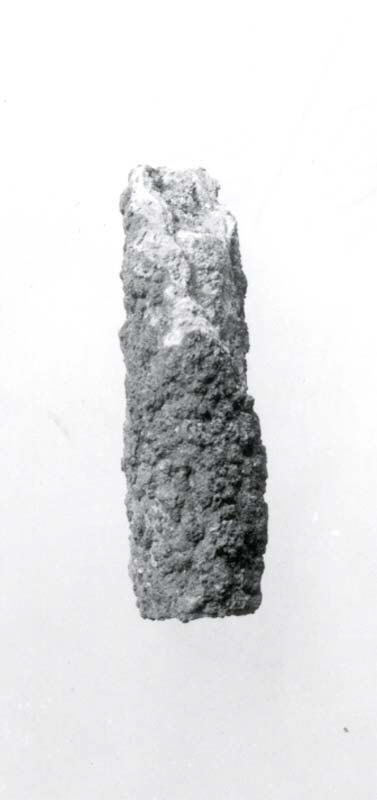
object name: tube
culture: assyrian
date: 900-601 BCE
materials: bronze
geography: mesopotamia